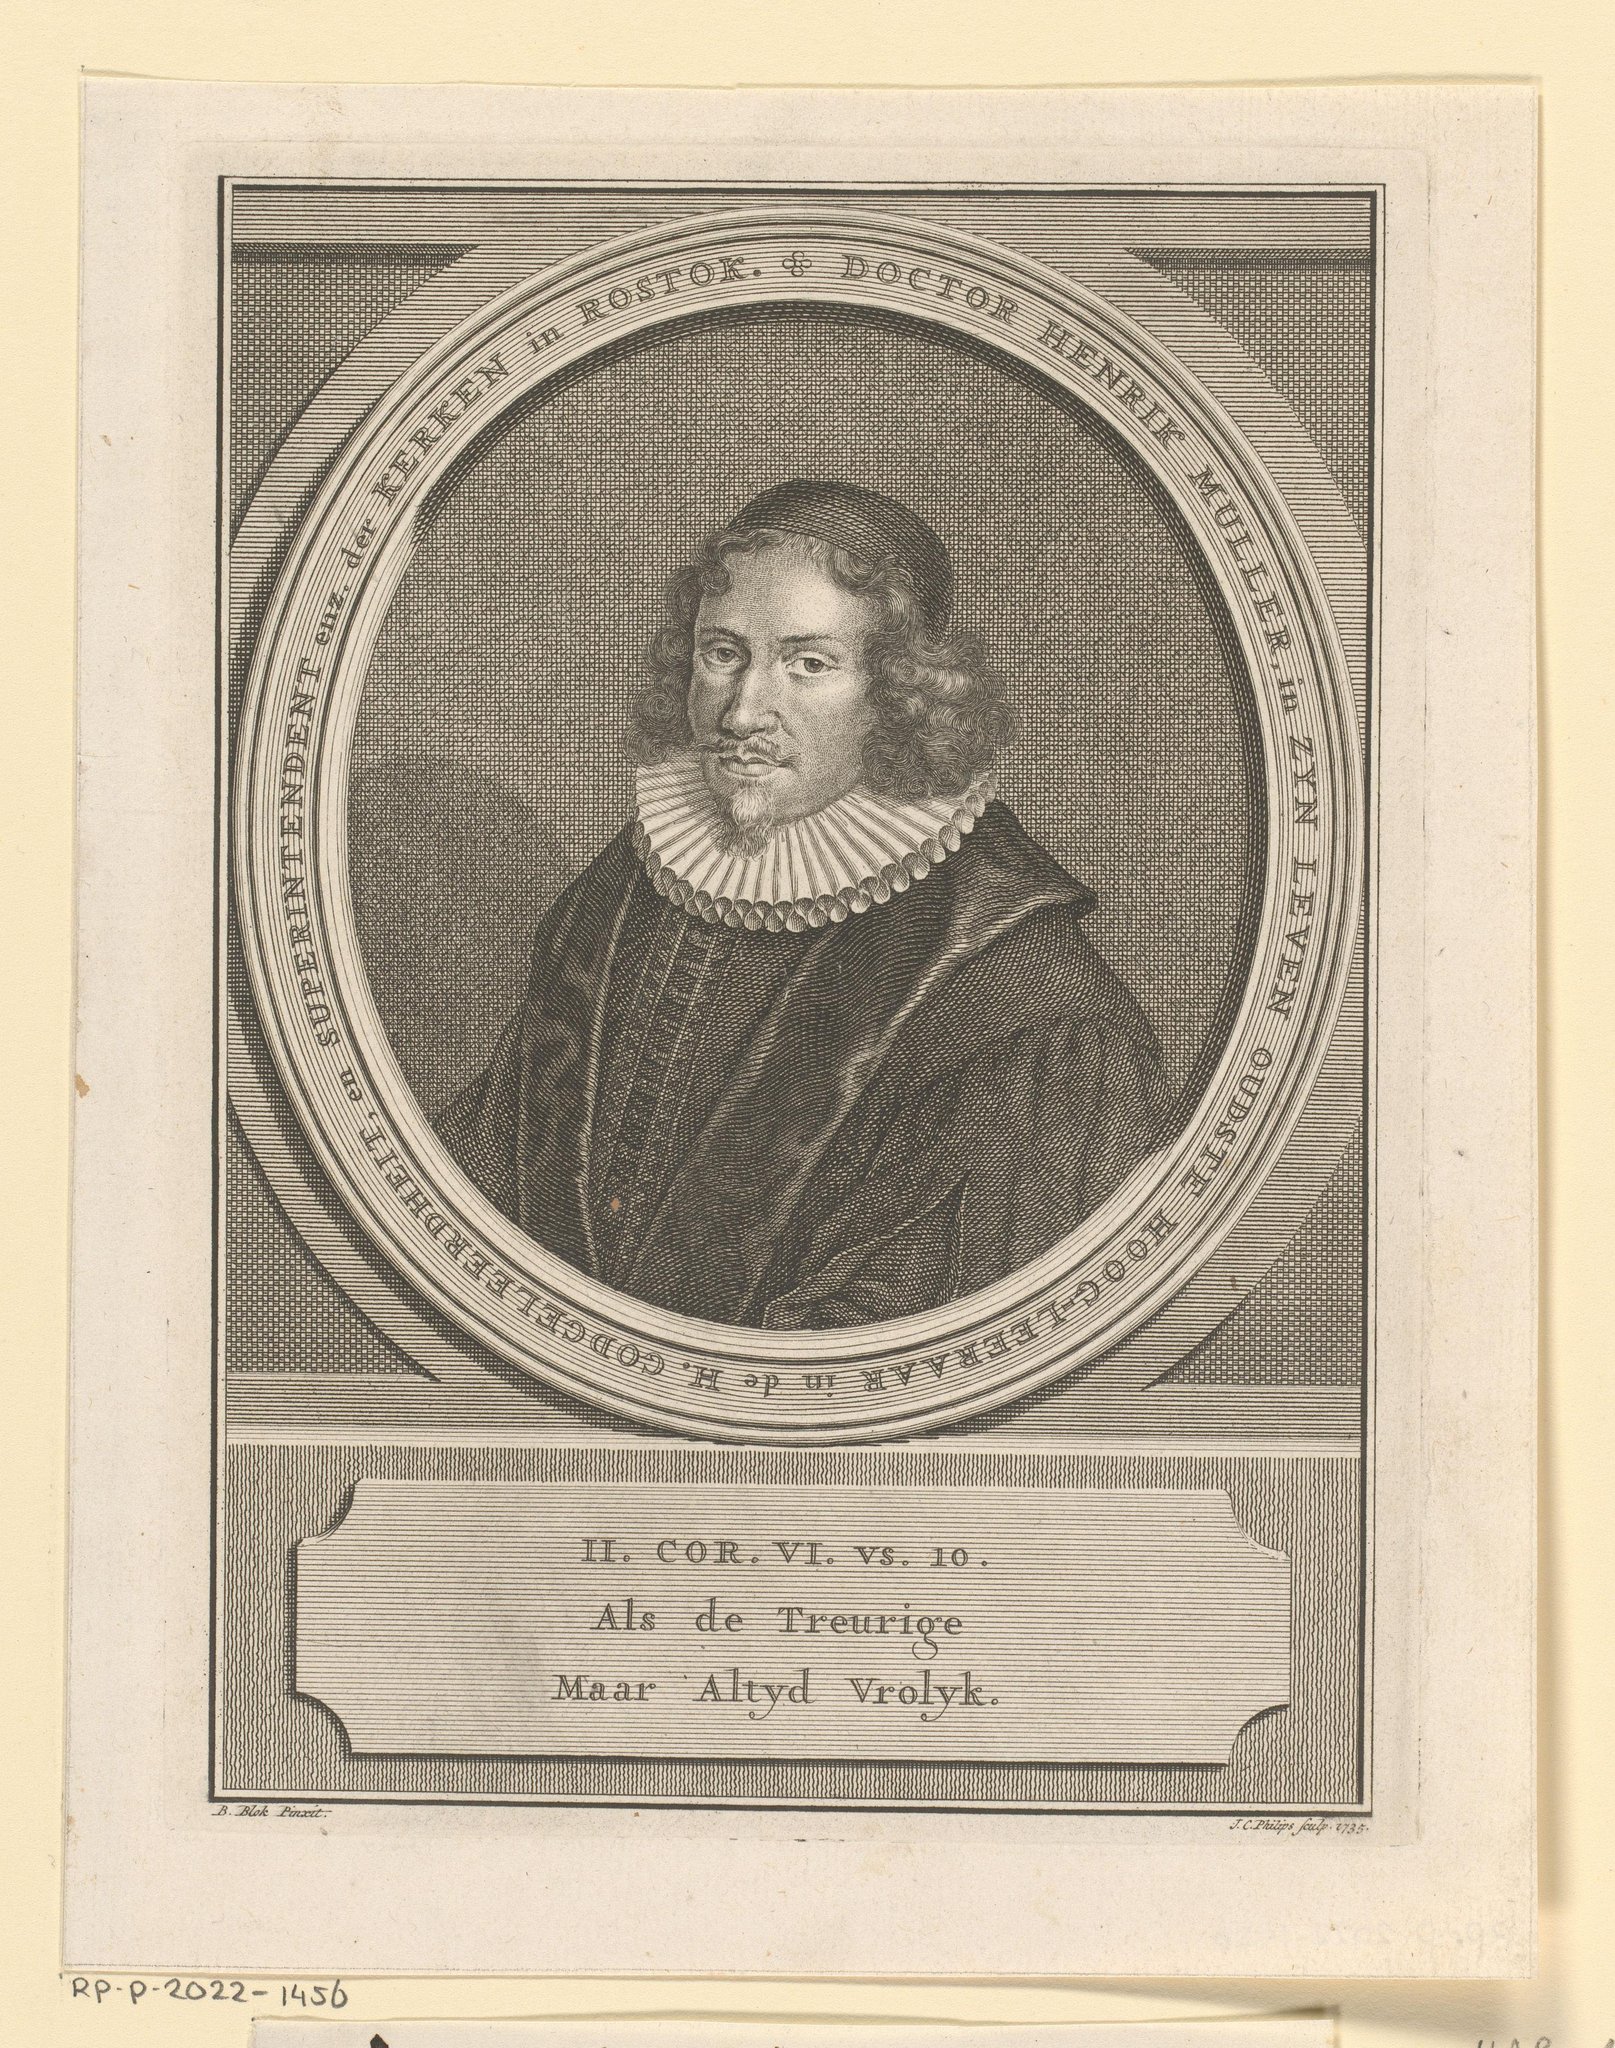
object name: print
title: Portret van Heinrich Müller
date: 1735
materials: paper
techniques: engraving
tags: theologian, historical persons